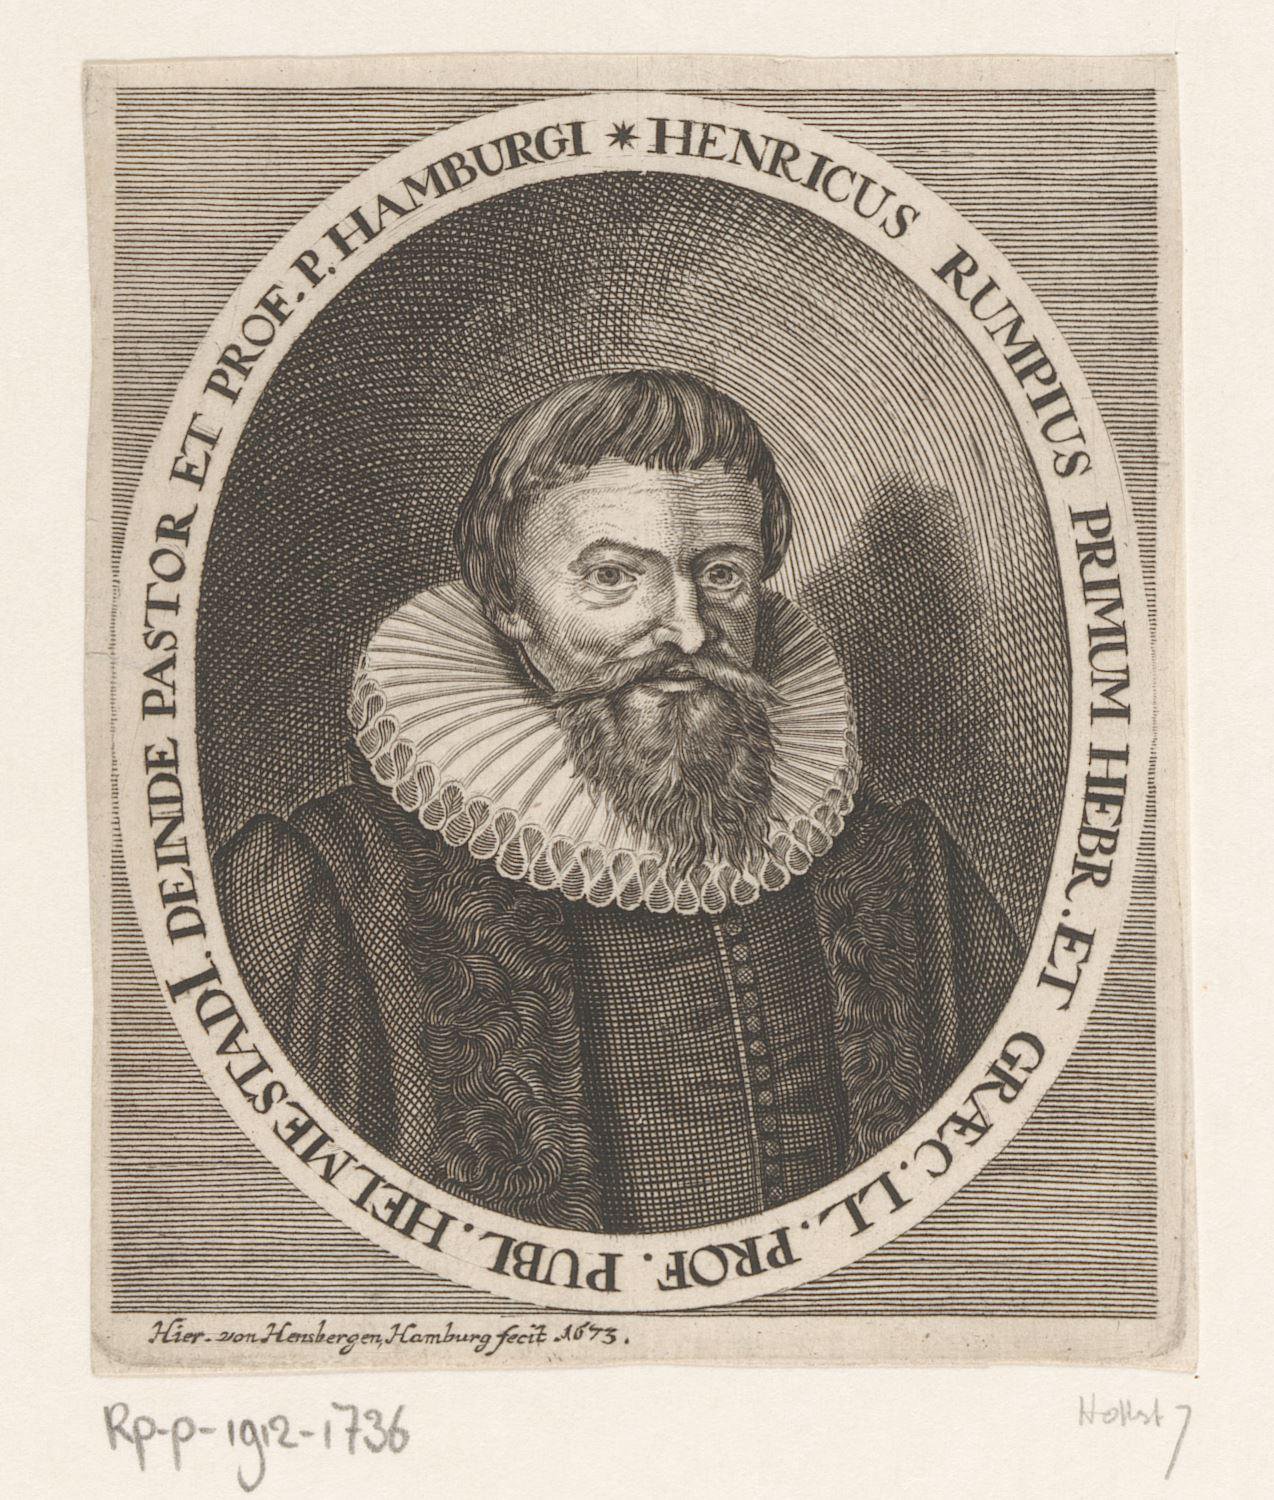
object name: print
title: Portret van Heinrich Rump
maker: hieronymus van hensbergen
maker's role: print maker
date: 1673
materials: paper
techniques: engraving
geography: hamburg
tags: historical persons, writer, poet, author, professor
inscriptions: collector's mark: Lugt 2228